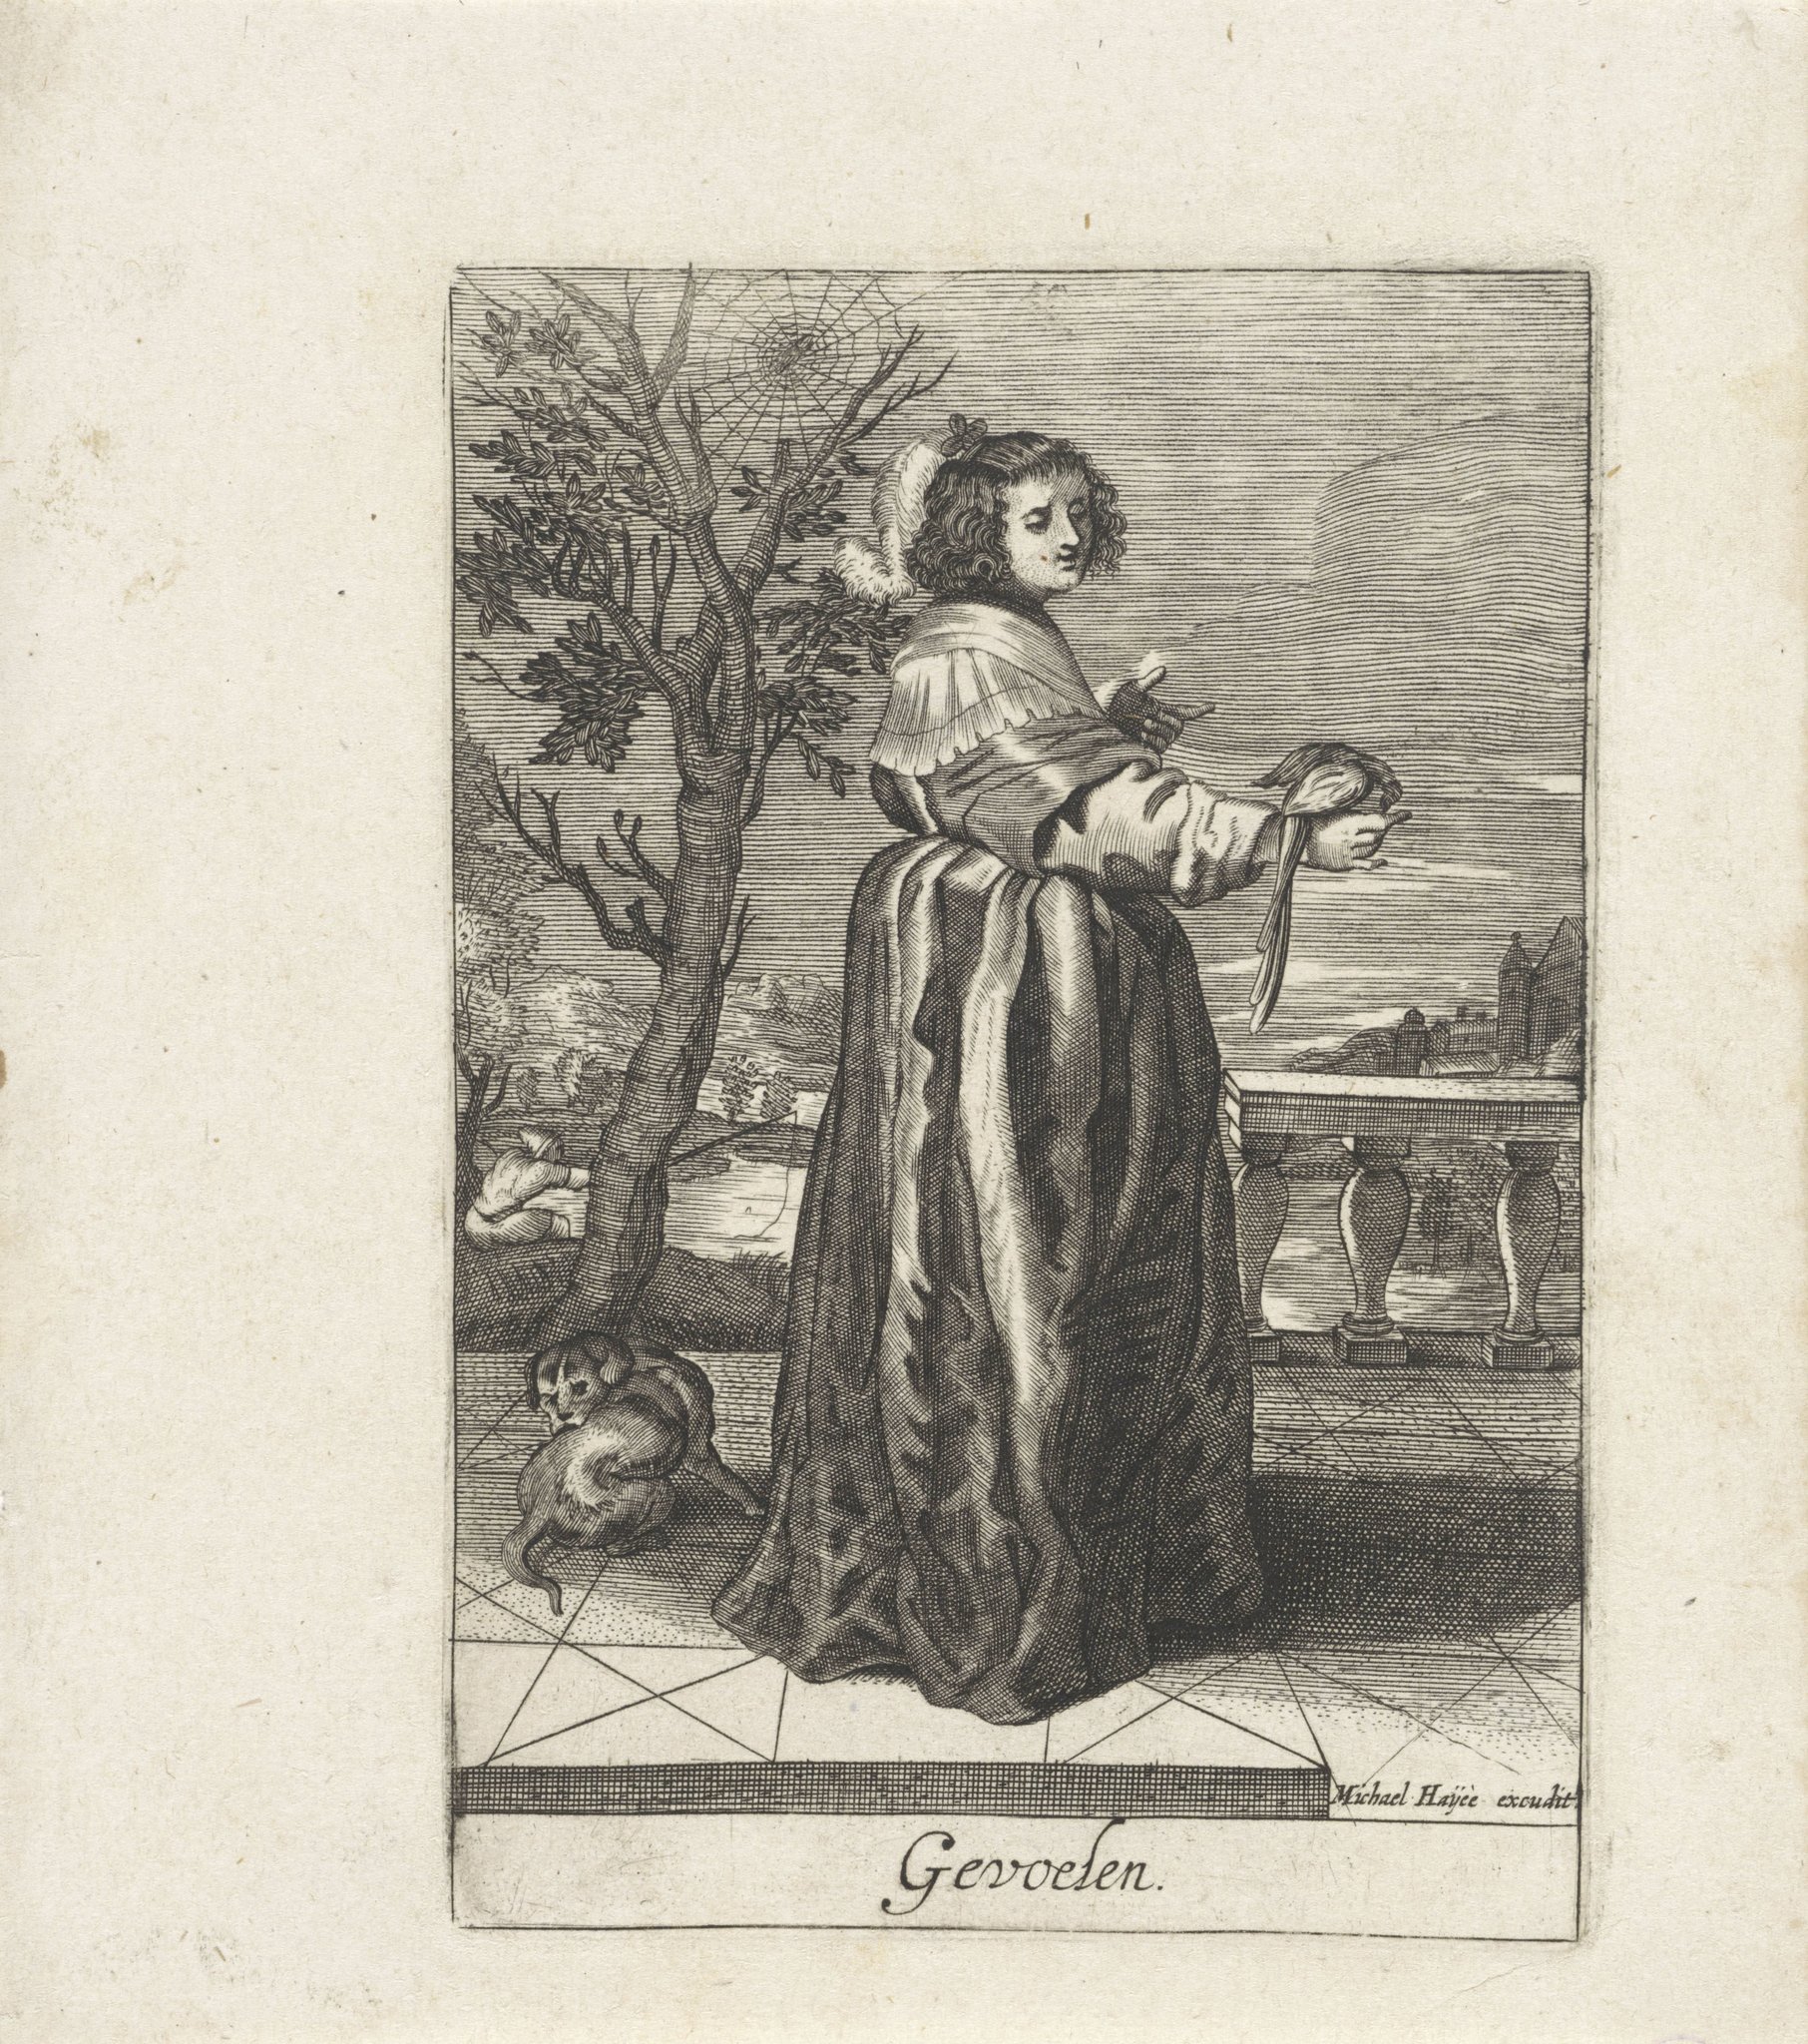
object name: print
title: Tastzin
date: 1600-1676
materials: paper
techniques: engraving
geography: low countries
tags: birds, feeling (one of the five senses), fisherman, dog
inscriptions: collector's mark: Lugt 2228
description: Personificatie van het zintuig Tastzin. Een vrouw wordt in haar vinger gepikt door een vogel. Achter haar twee stoeiende honden. Op de achtergrond een visser aan de oever van een meer.